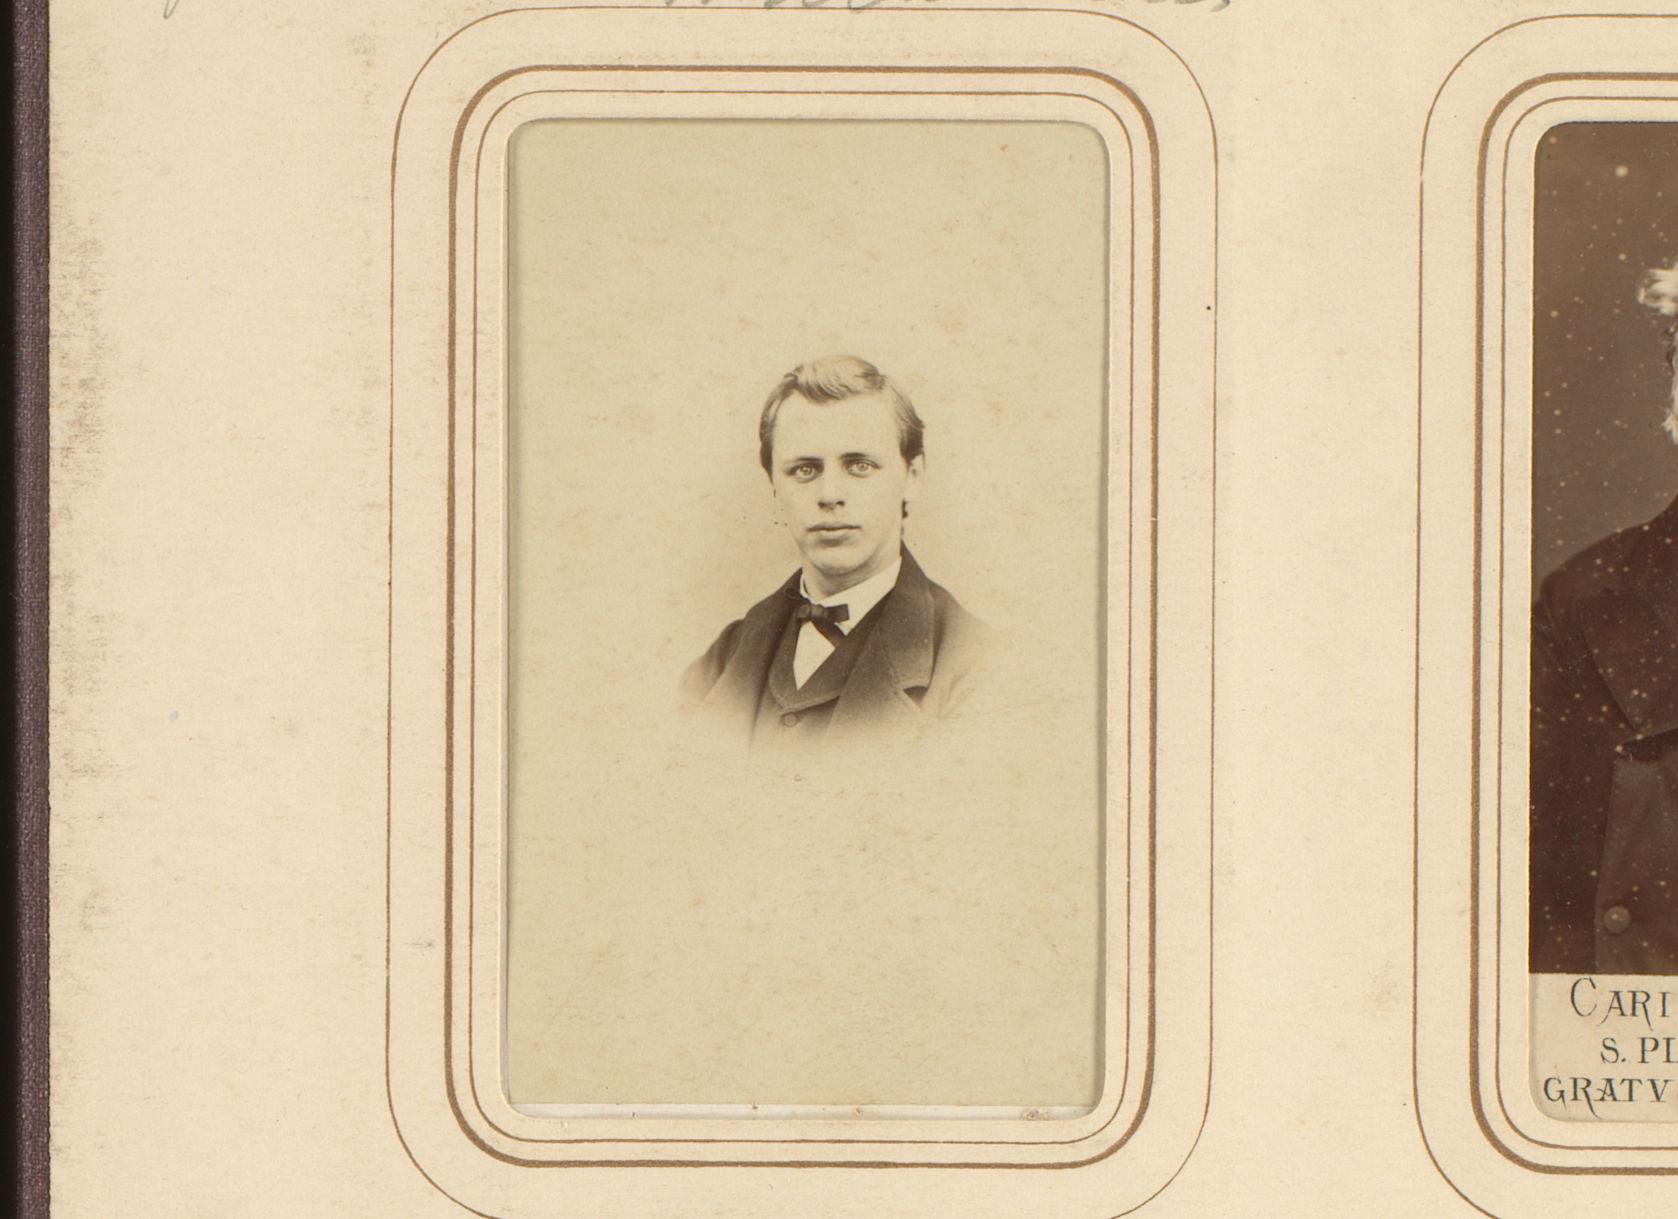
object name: album leaf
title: Portret van jonkheer Gerard Jacob Theodoor Beelaerts van Blokland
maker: bernardus bruining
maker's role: fotograaf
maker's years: 1834-1900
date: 1865-1890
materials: cardboard, photographic support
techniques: albumen print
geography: leiden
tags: adult man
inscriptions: annotation: ‘G. J. Beelaerts/ van Blokland/ 17-6-68/ Juni 66.’, inscription: ‘B. Bruining/ Leyden’